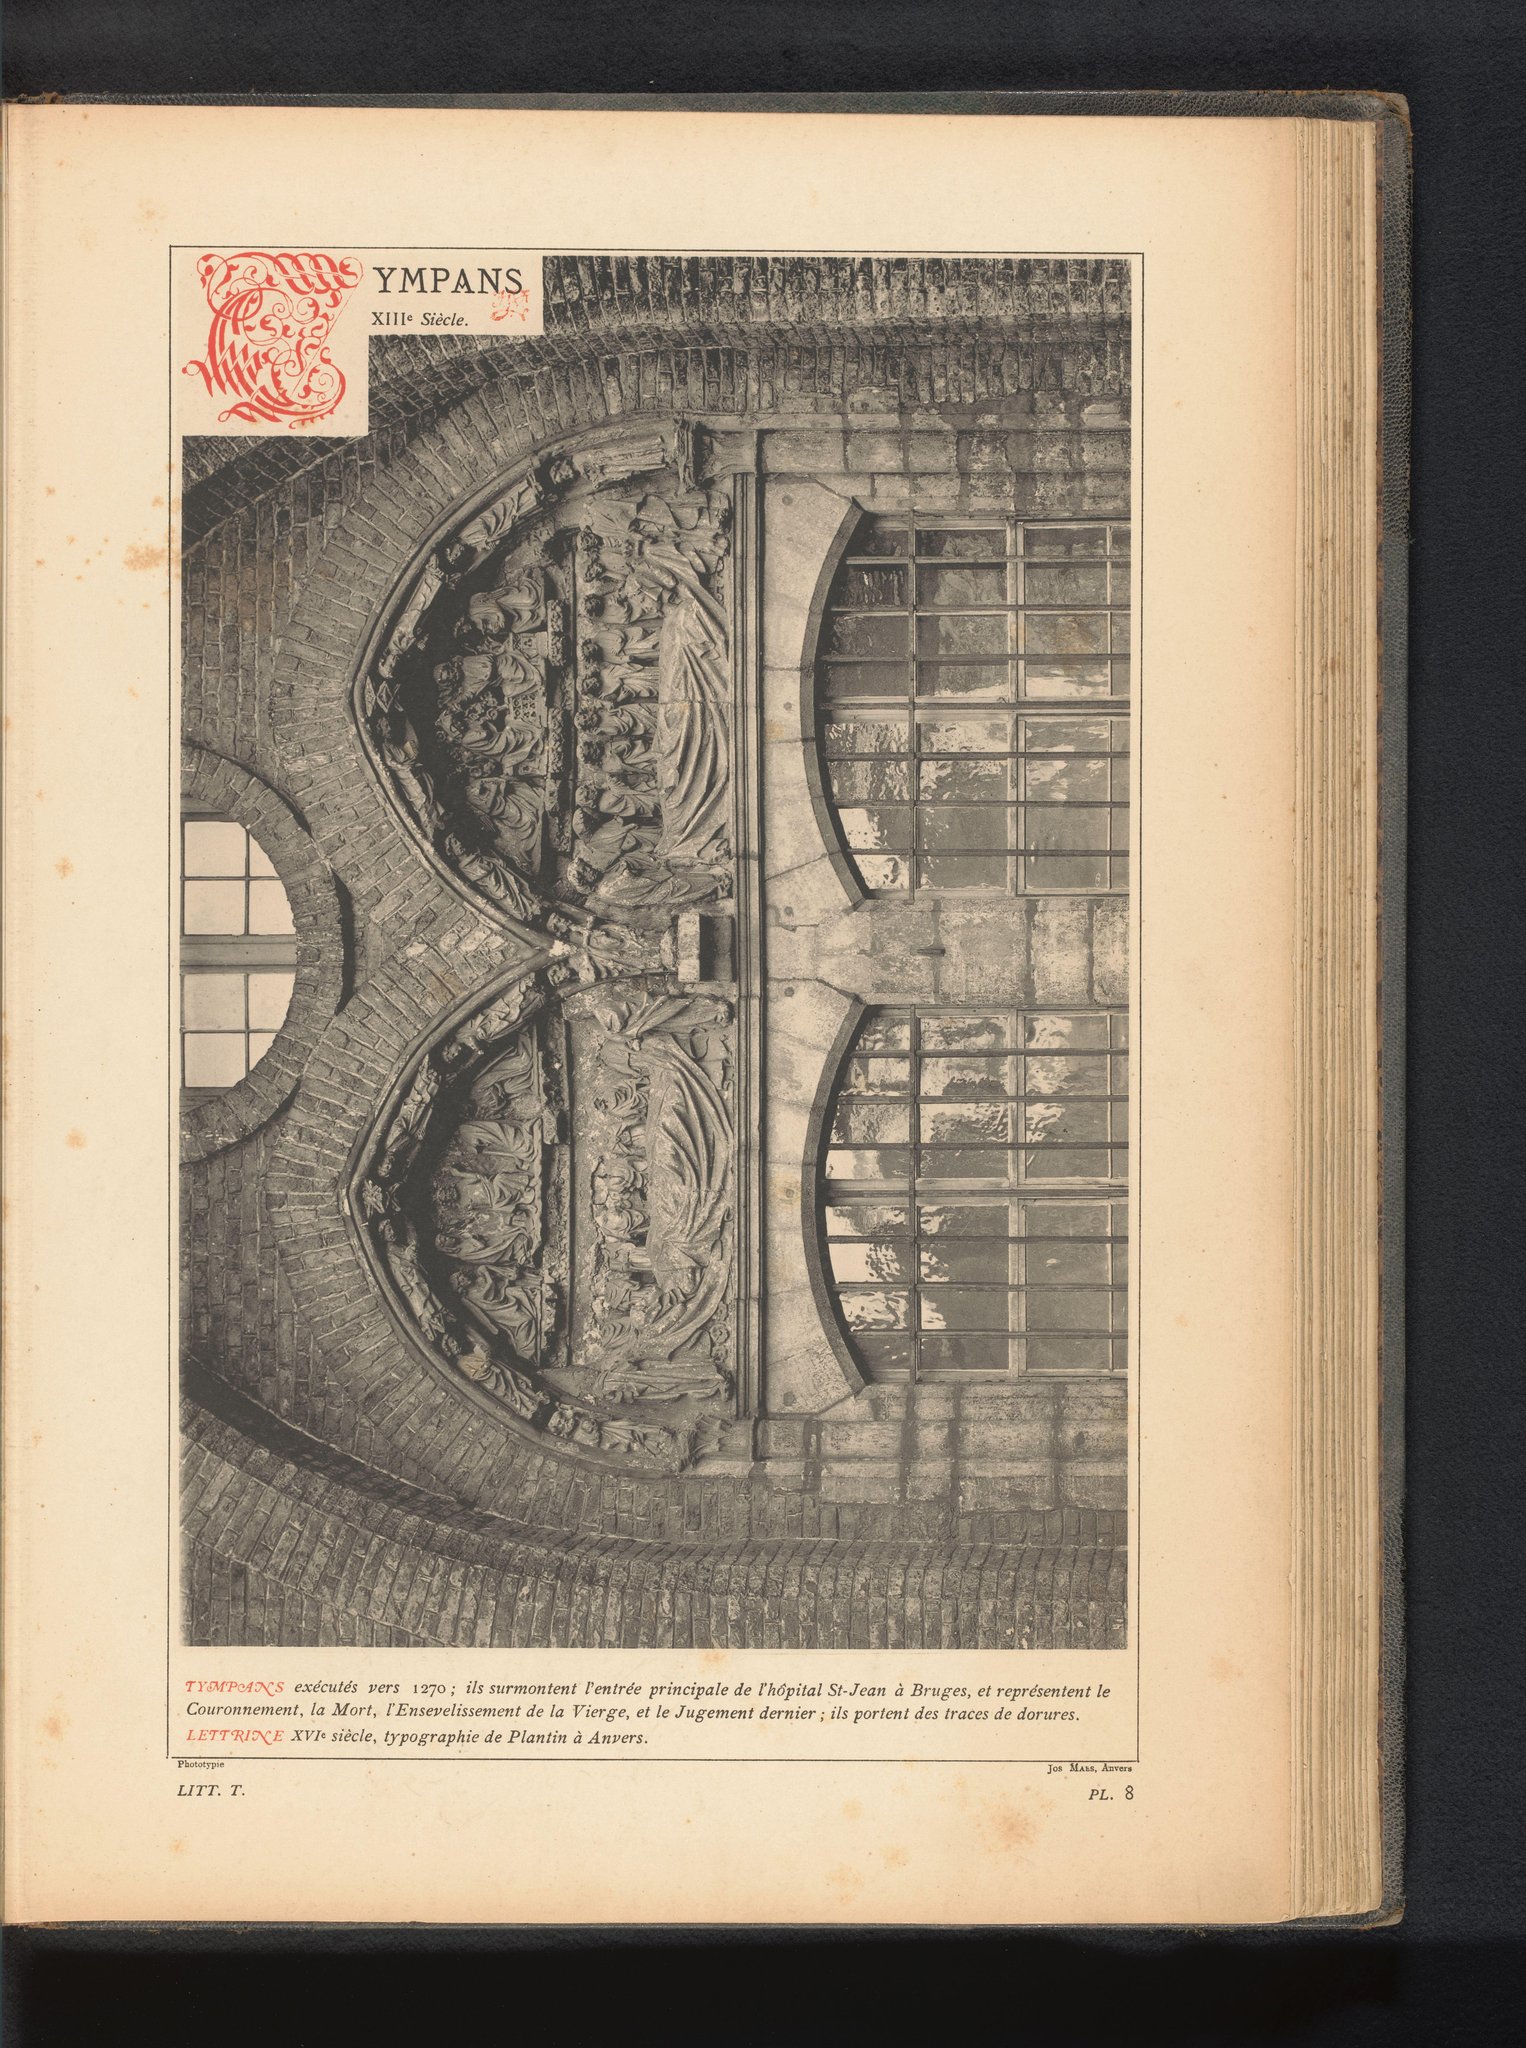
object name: photomechanical print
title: Timpanen van het Sint-Janshospitaal te Brugge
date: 1876-1881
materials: paper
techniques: photograph, photolithography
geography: bruges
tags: parts of church exterior and annexes: tympanum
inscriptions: inscription: ‘LITT. T. - PL. 8.’, monogram: ‘JJvY’, inscription: ‘TYMPANS exécutés vers (...)’